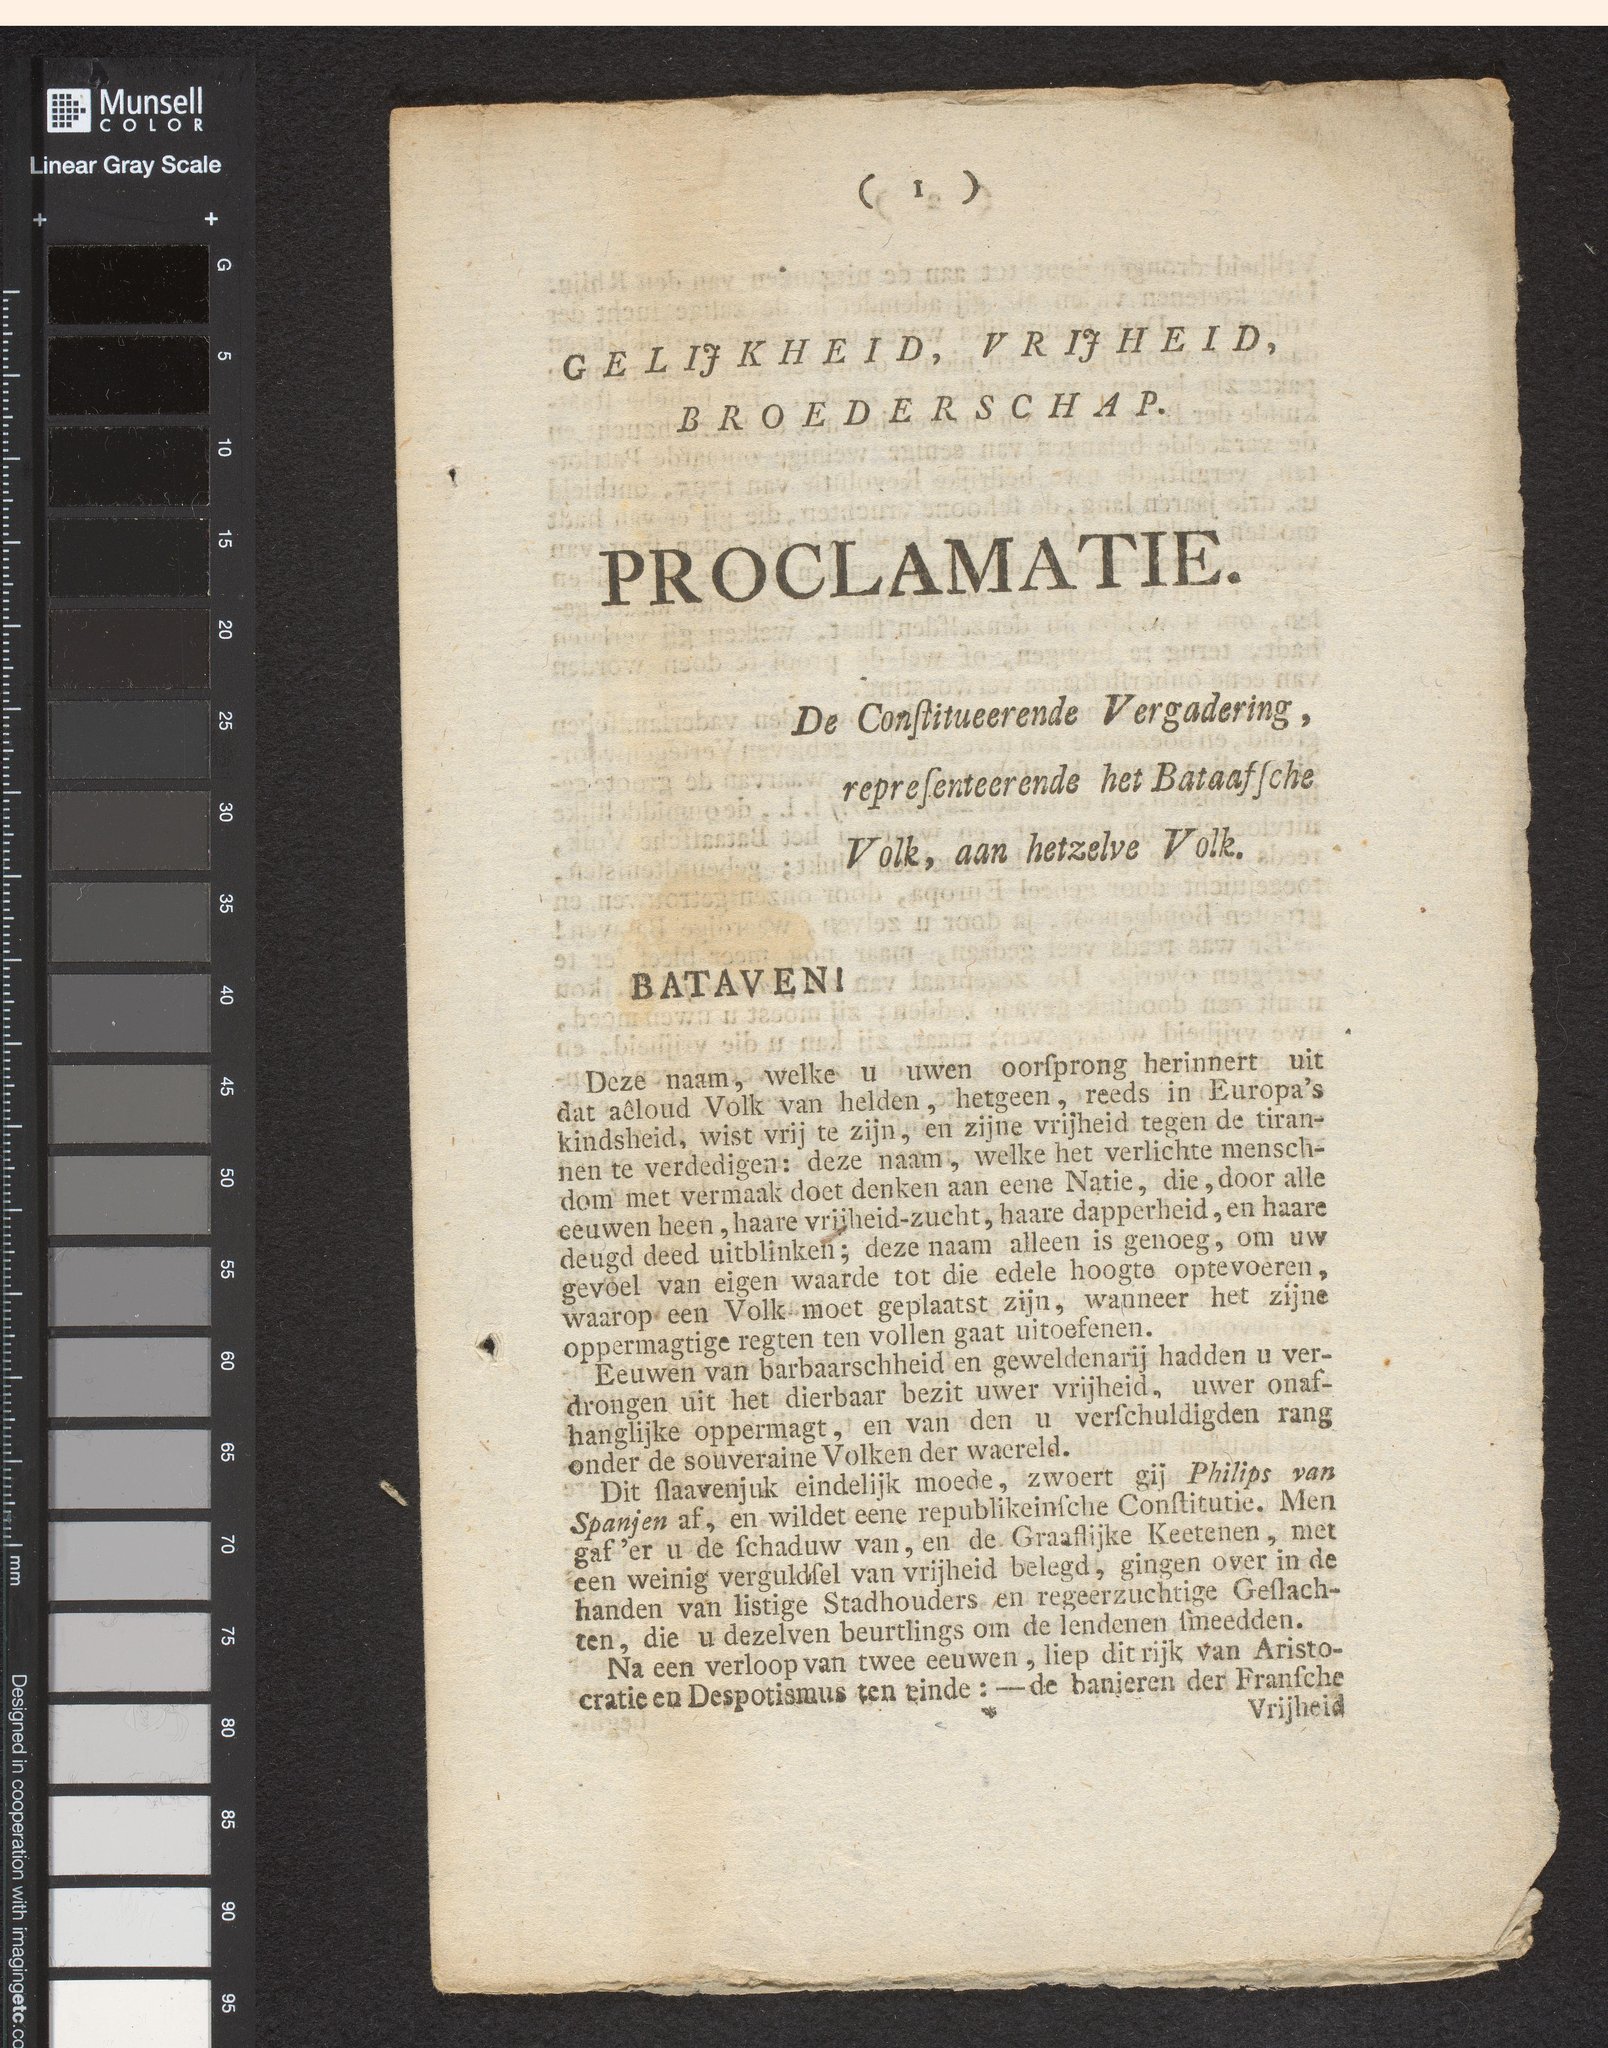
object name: pamphlet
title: Proclamatie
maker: adrianus ploos van amstel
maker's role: politician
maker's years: 1749-1816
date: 1798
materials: paper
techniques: printing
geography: the hague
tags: netherlands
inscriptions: date